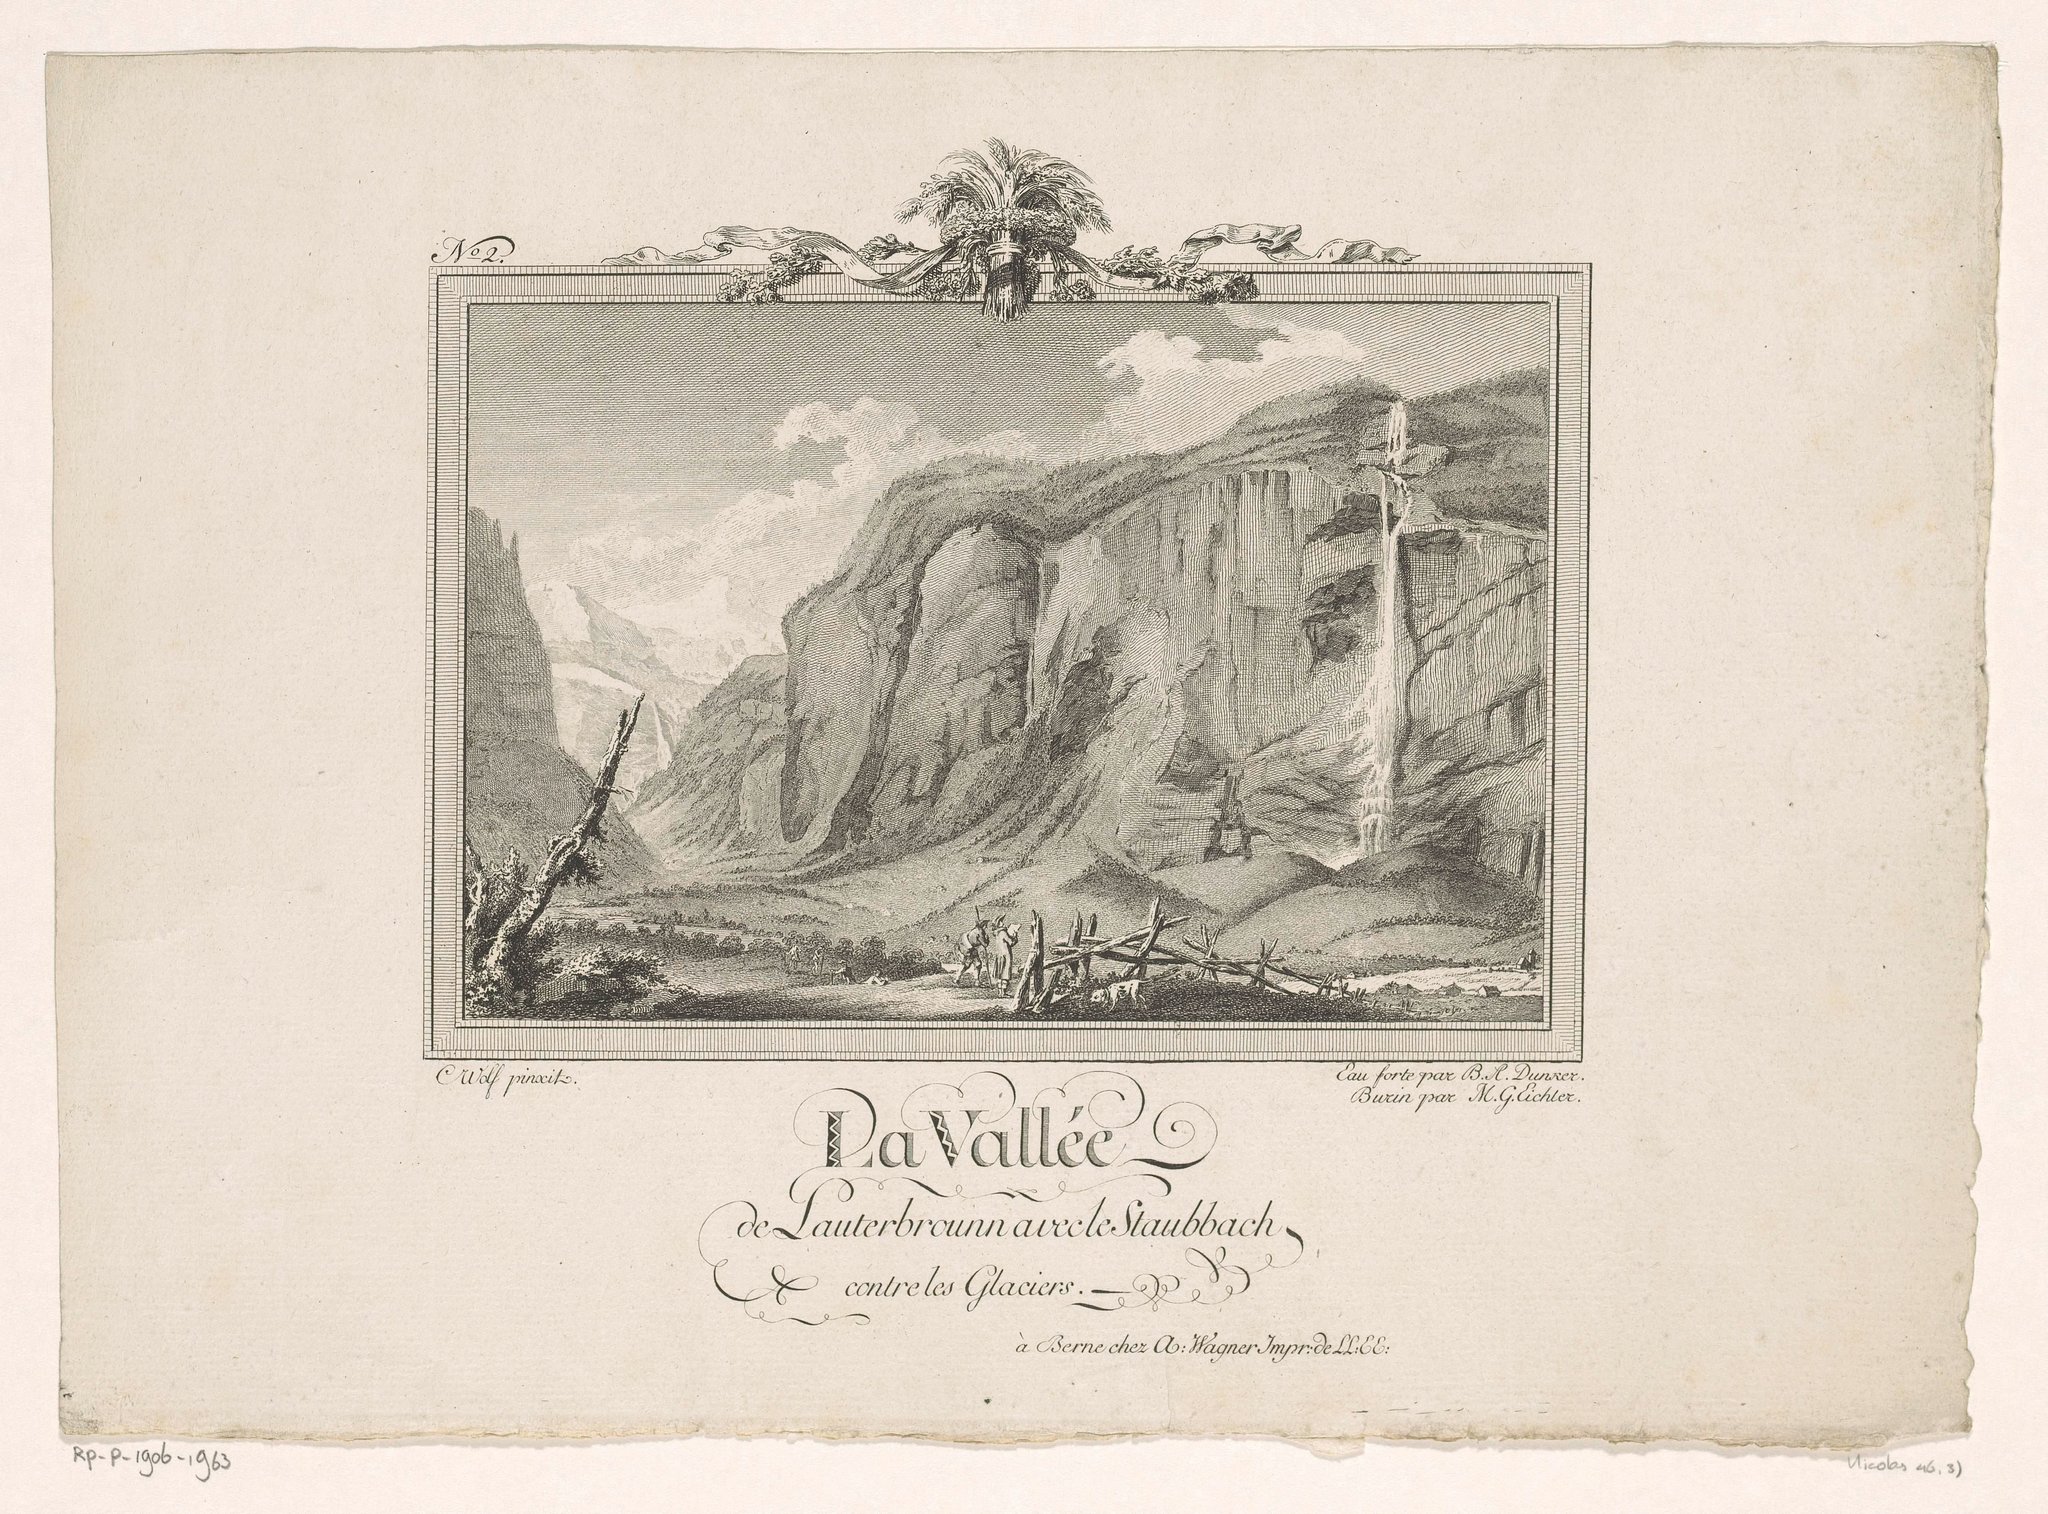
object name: print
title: De vallei van Lauterbrunnen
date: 1776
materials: paper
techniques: etching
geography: bern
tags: dale, valley, waterfall, fence, wall, paling, 'en route', traveller under way, mountains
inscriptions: collector's mark: Lugt 2228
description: Prent gebruikt voor: Wyttenbach, Jakob Samuel. Vues remarquables des montagnes de la Suisse avec leur description. Bern: A. Wagner, 1776.